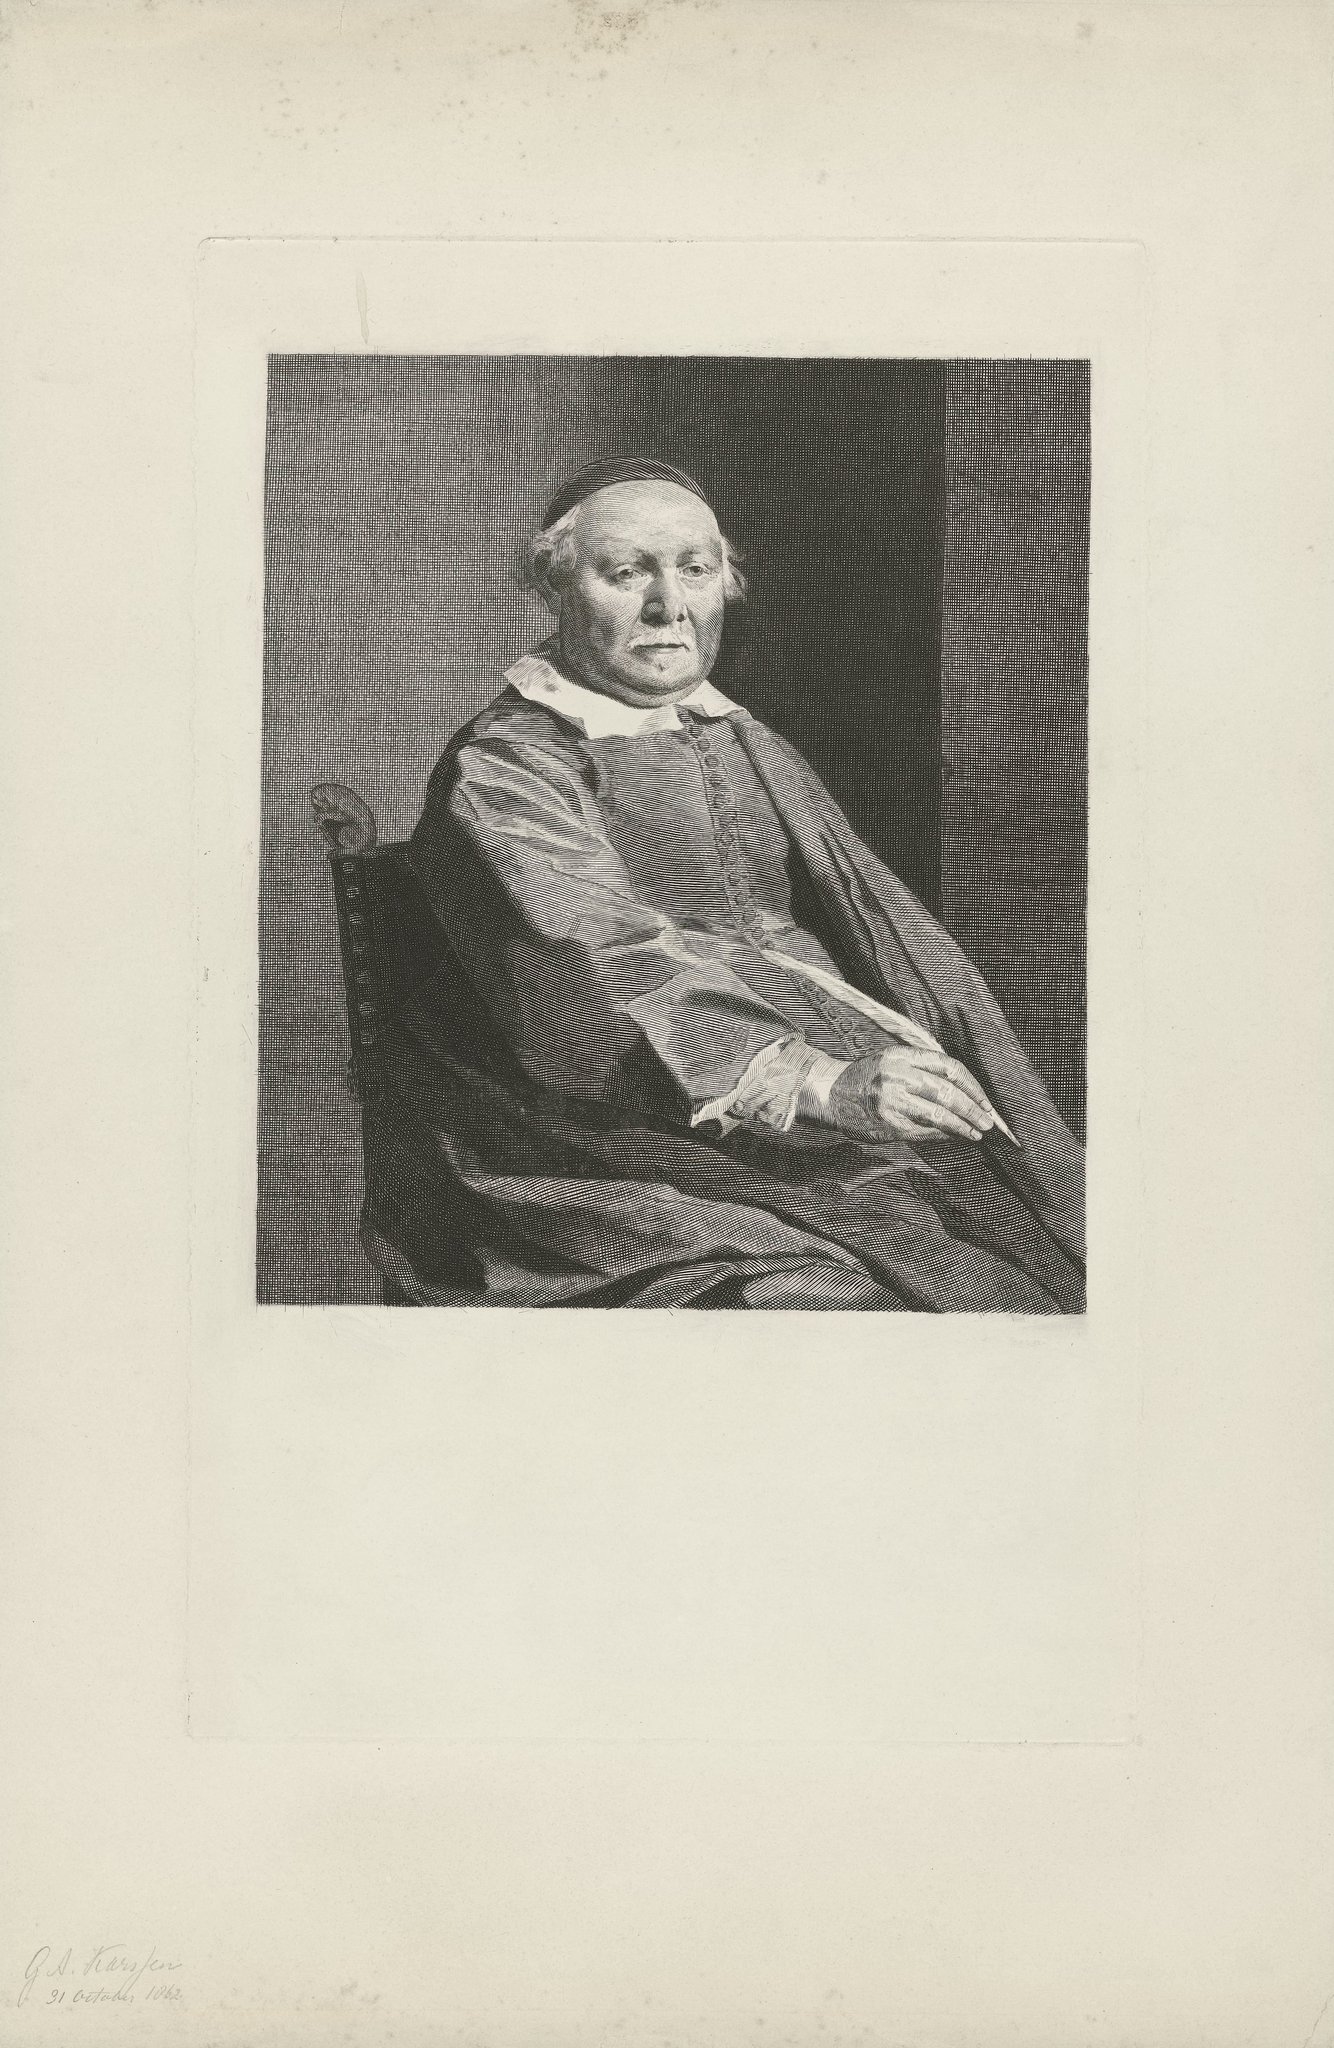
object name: print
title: Portret van Lieven Willemsz. van Coppenol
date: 1862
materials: paper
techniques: engraving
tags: amsterdam, draughtsman, lieven willemsz. coppenol, quill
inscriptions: inscription: ‘G.A. Karsen 31 October 1862’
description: Portret ten halven lijve van schoonschrijver Lieven Willemsz. van Coppenol. Van Coppenol zit in een vertrek op een stoel met een schrijfveer in zijn hand.